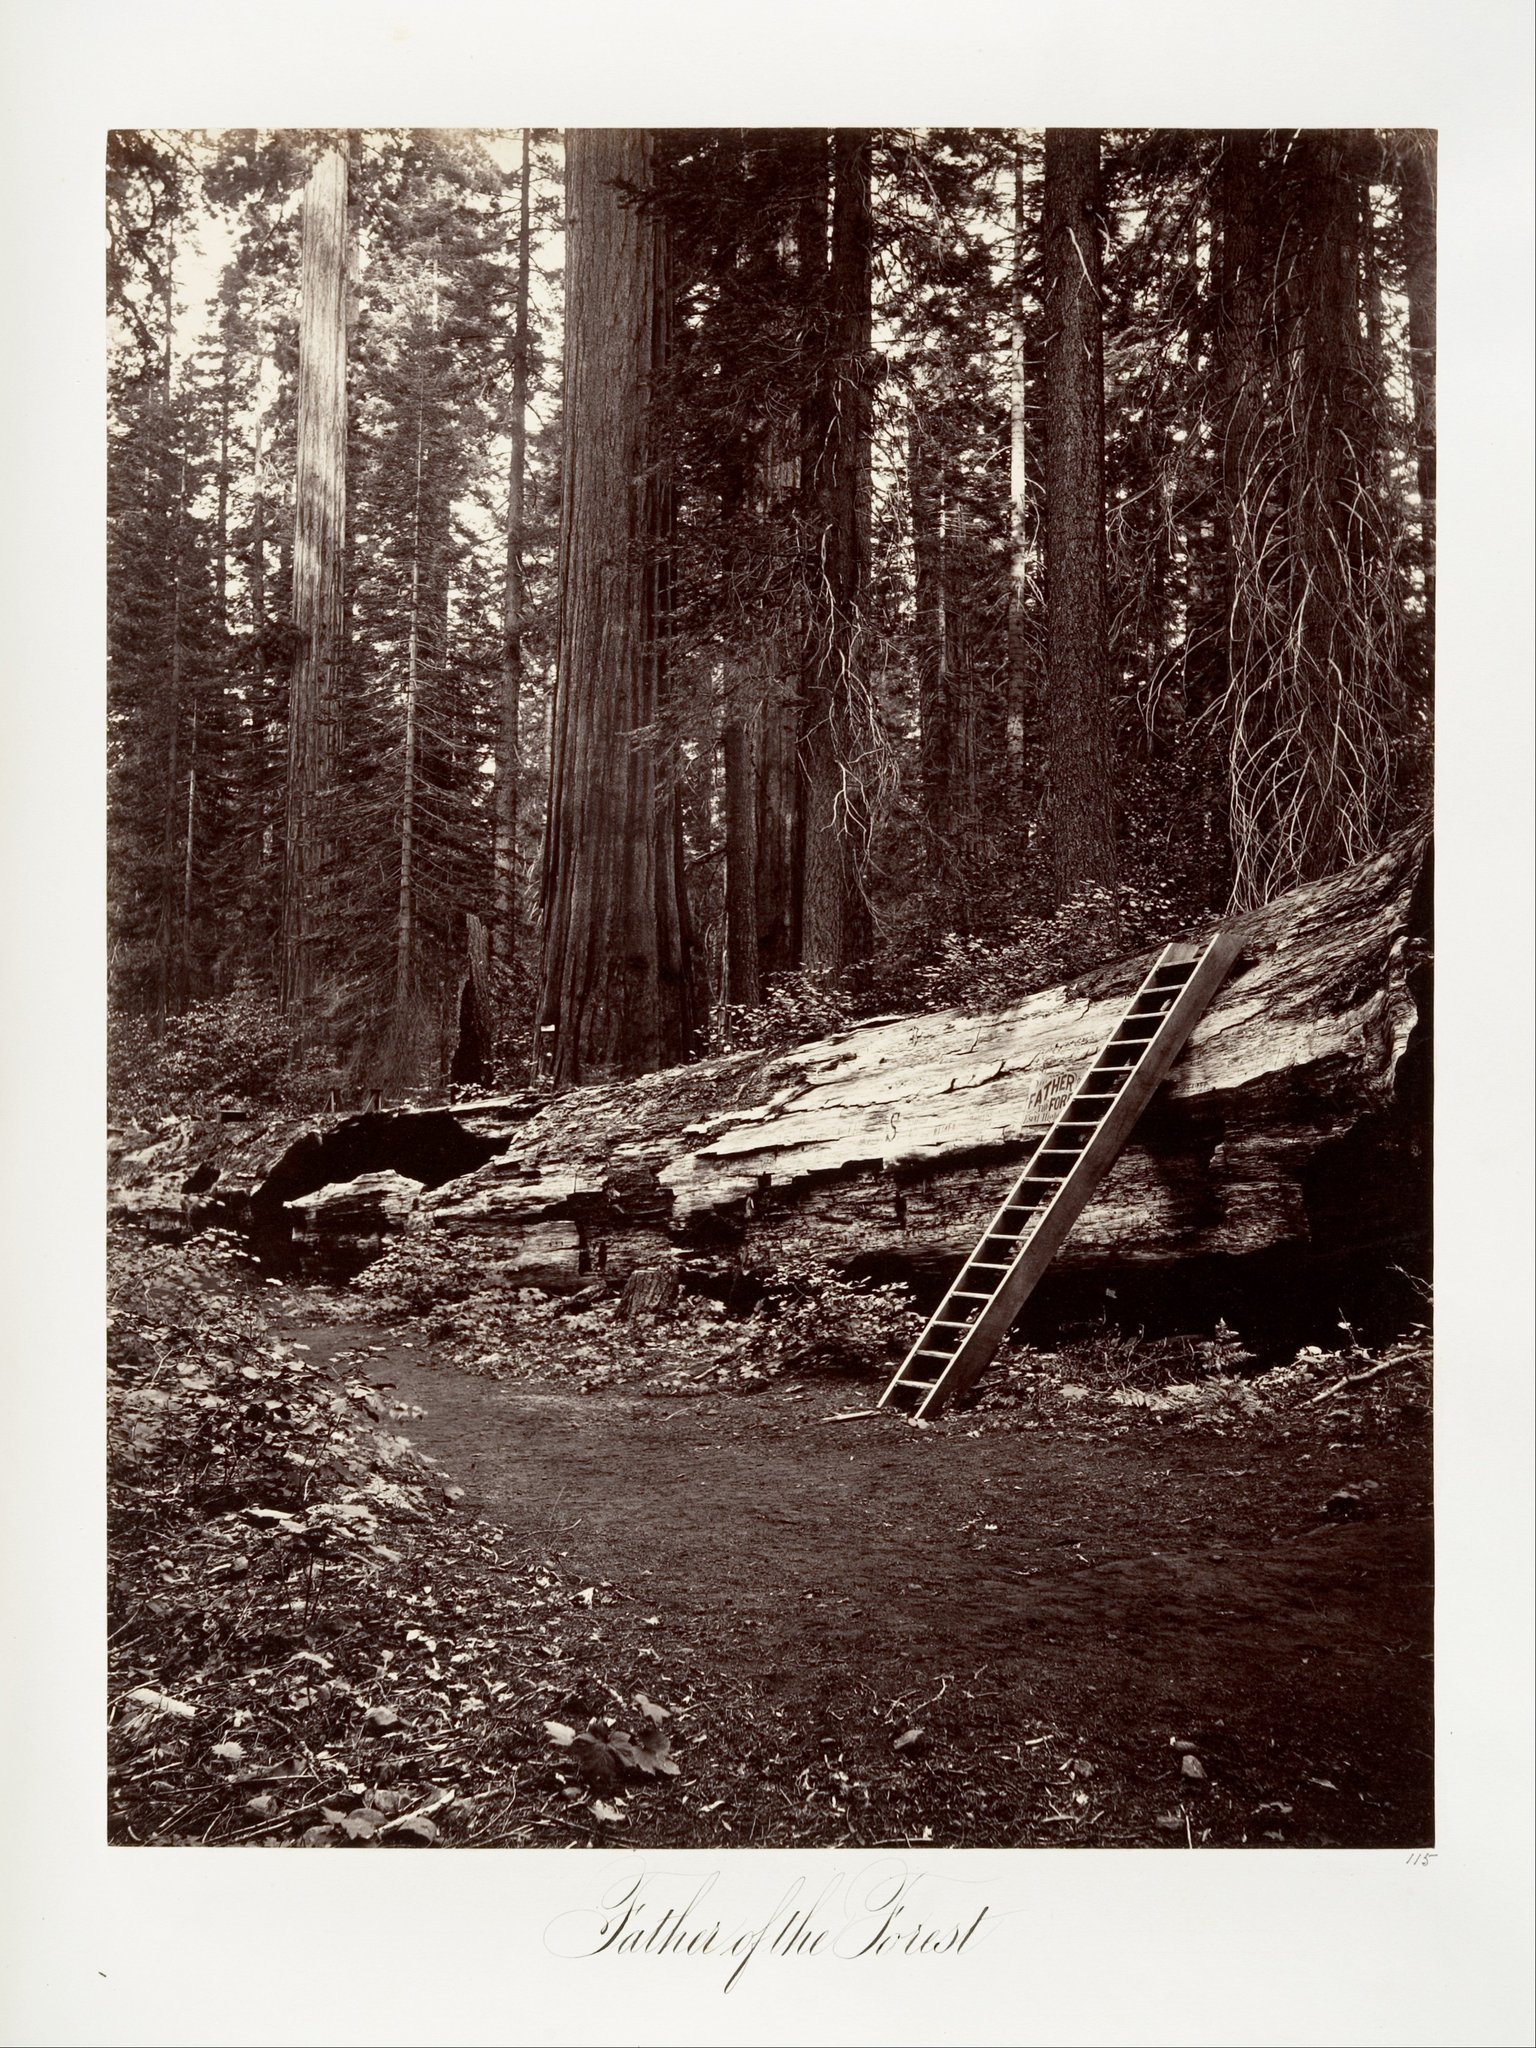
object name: photograph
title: Father of the Forest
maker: carleton e. watkins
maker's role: artist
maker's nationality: american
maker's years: 1829-1916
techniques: albumen silver print, glass negative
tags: forests,landscapes